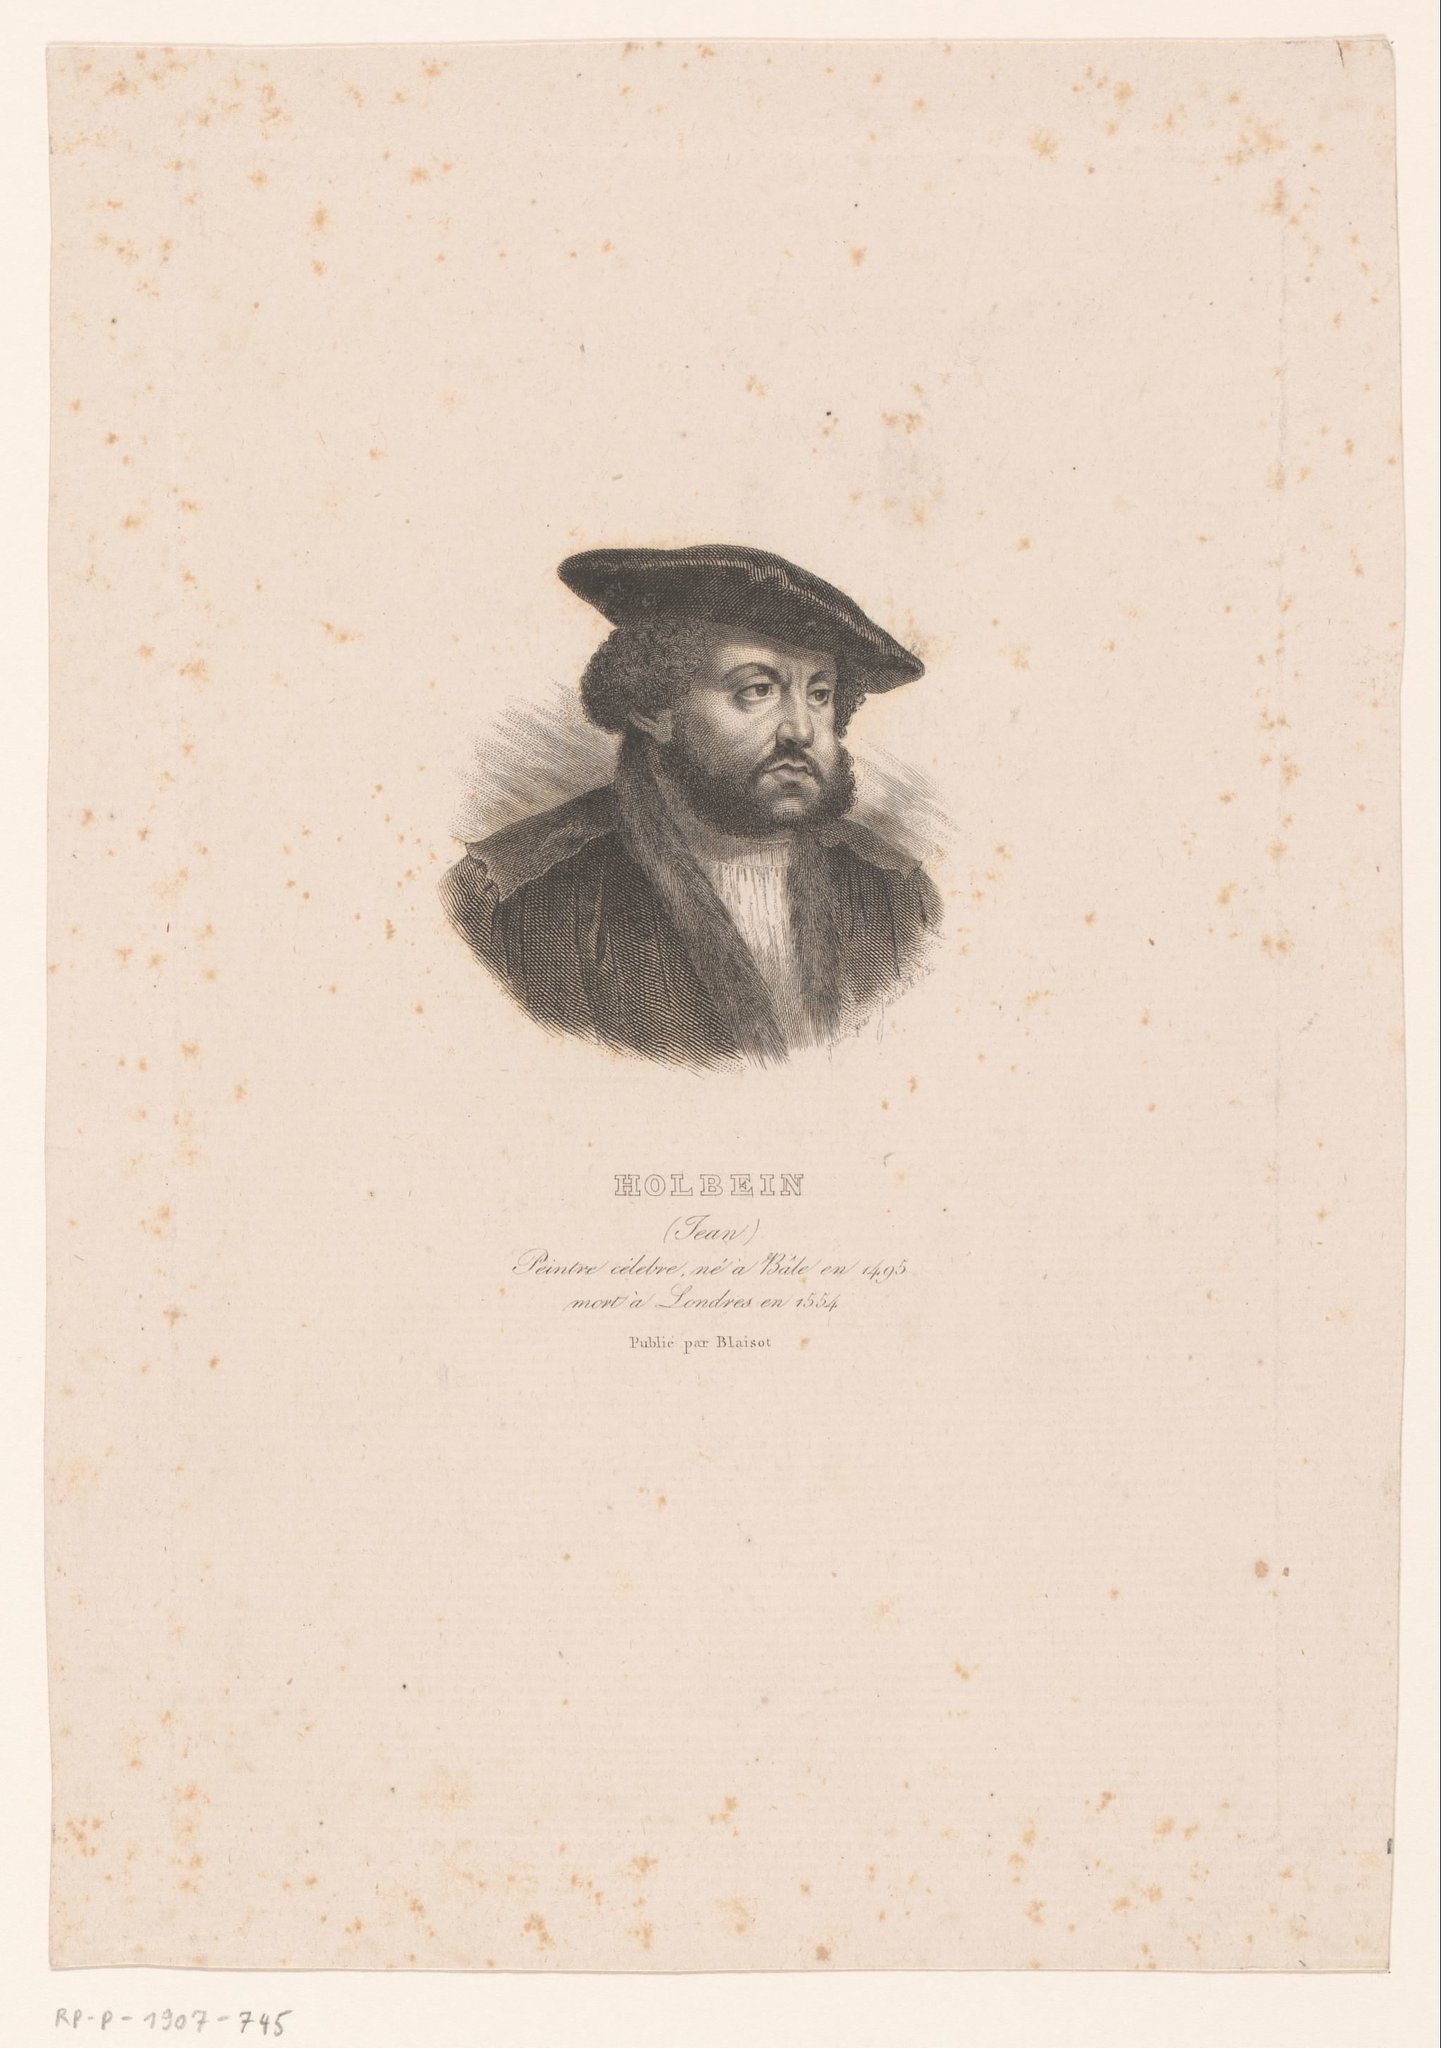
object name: print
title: Portret van Hans Holbein II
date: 1832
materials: paper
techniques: engraving, etching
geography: france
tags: augsburg, london, draughtsman, hans holbein (ii), historical persons, portrait, self-portrait of painter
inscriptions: collector's mark: Lugt 2228